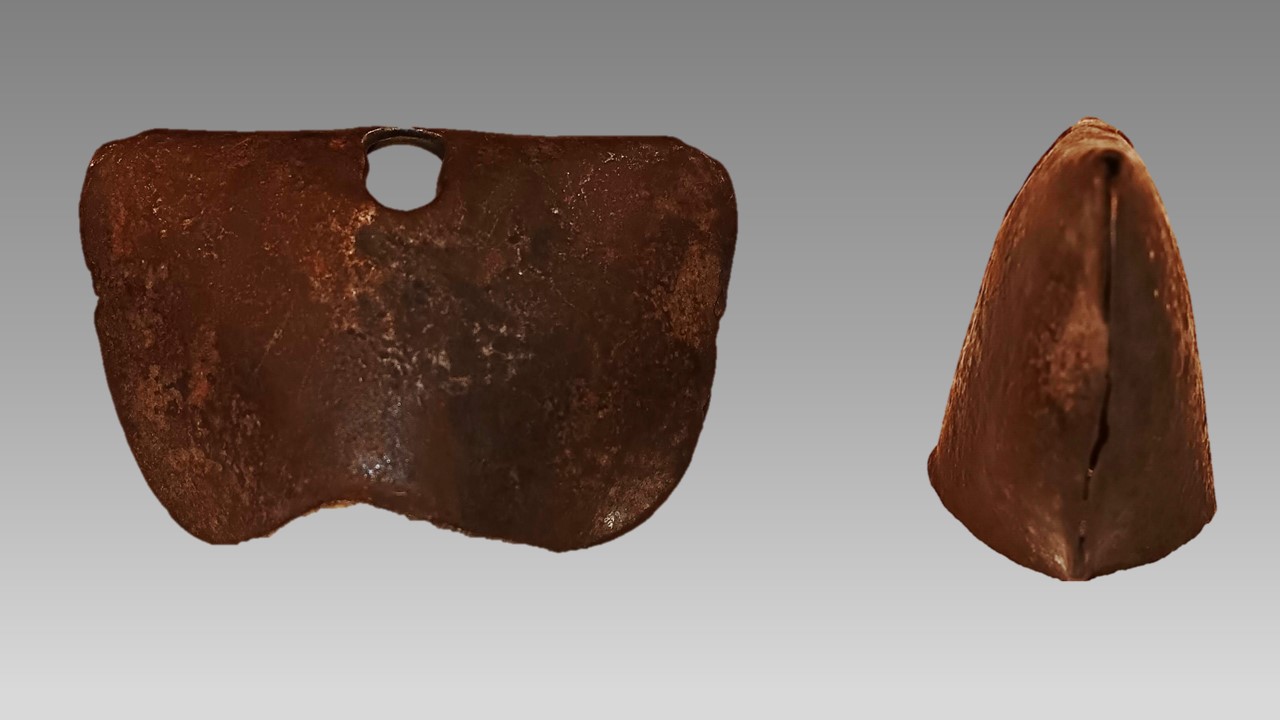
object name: ngonge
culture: congolese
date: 1867-1900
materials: iron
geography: democratic republic of the congo